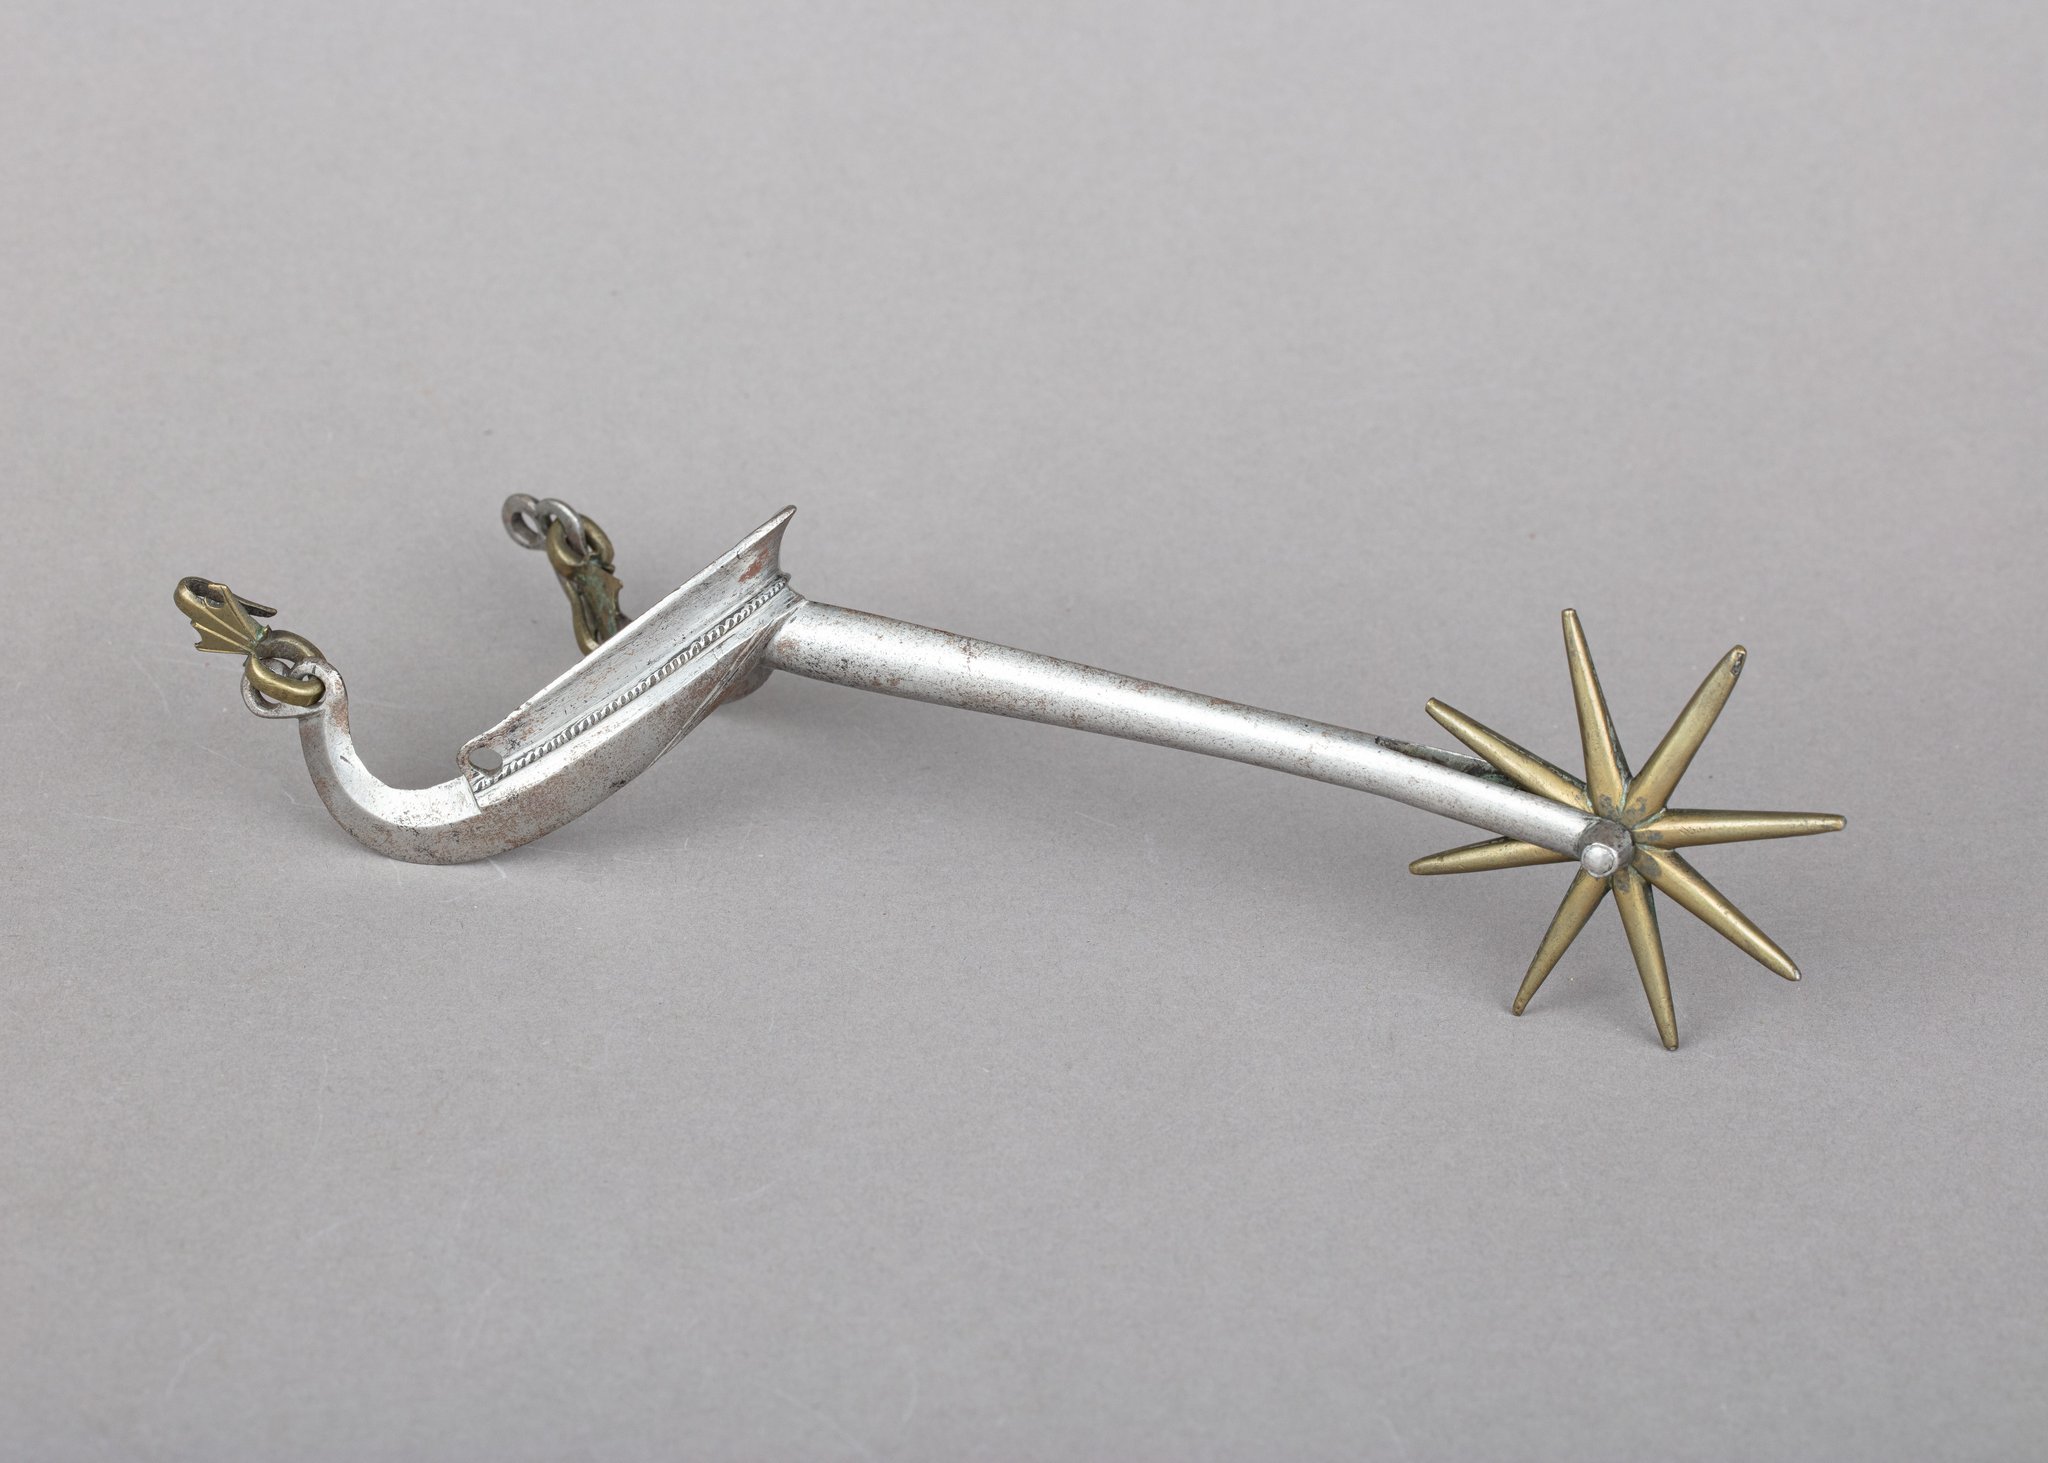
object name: spur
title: Rowel Spur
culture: german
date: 1401-1500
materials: copper alloy, metal alloy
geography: germany